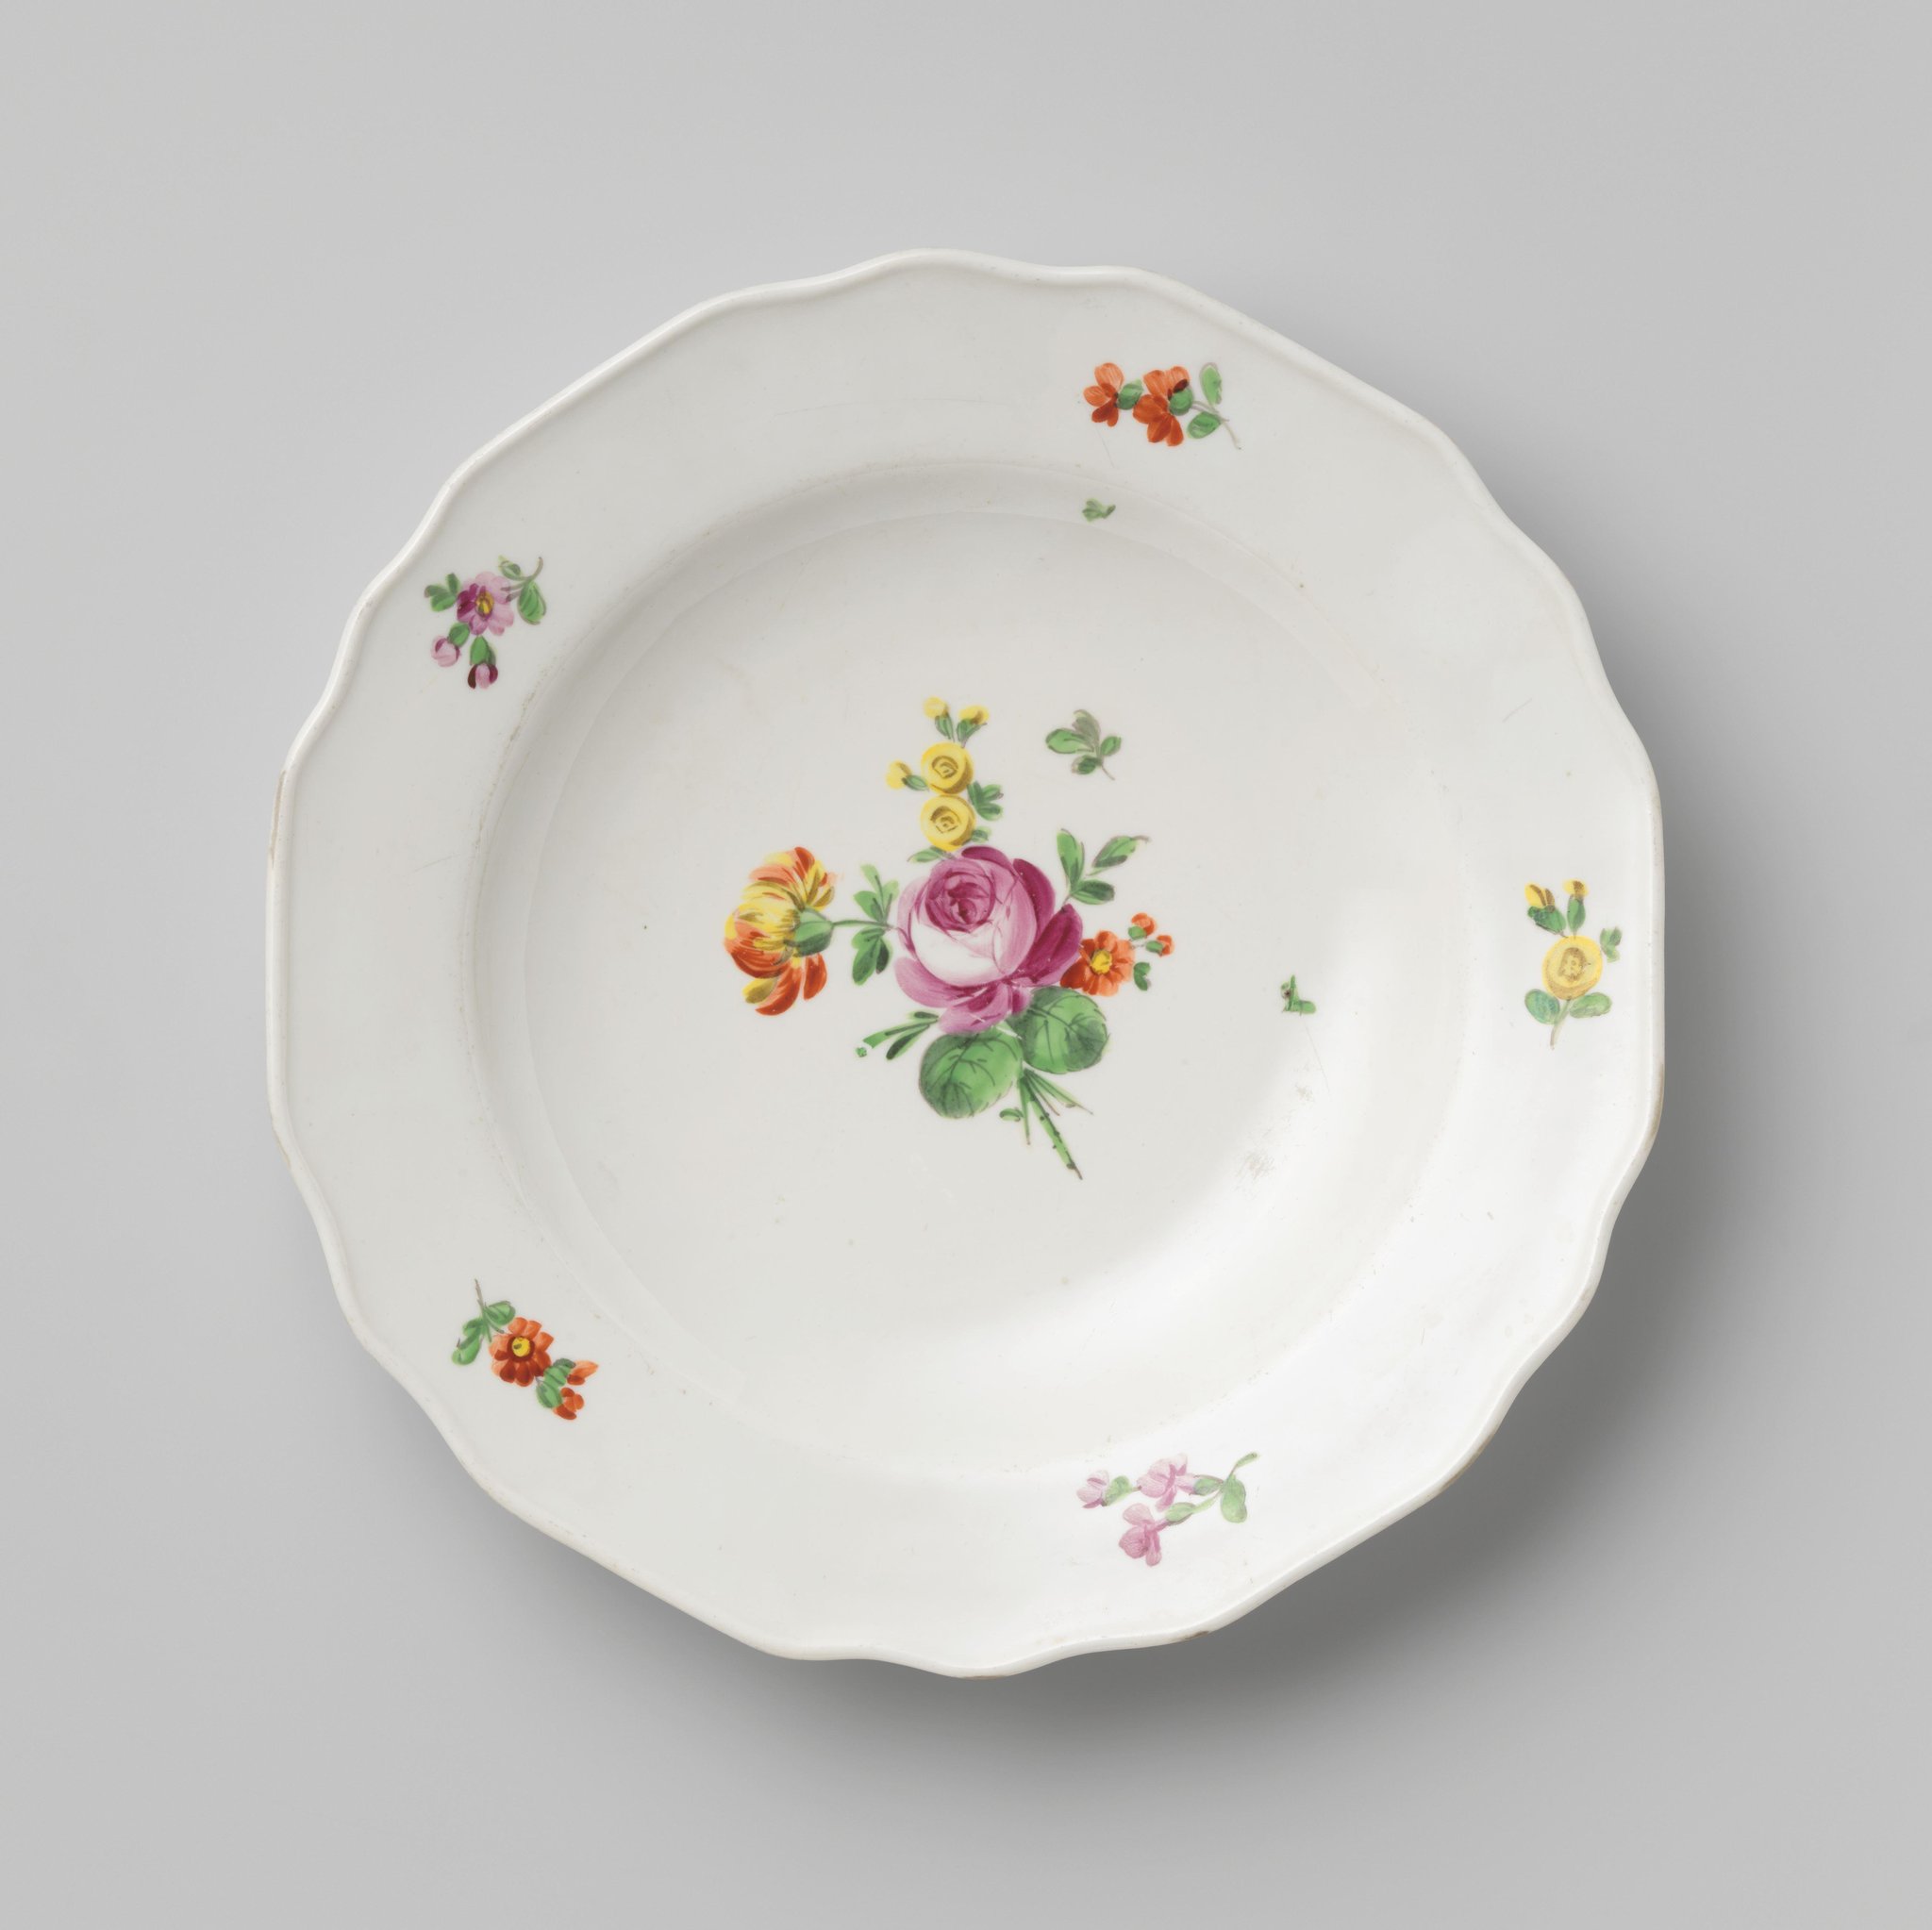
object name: service set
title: Plate with a bouquet and flower sprays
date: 1800-1849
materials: glaze, paint, porcelain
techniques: firing, forming, turning, vitrification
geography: vienna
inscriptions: mark: ‘schild/ P/ 30./ 23/ 35’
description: Bord van porselein met een gelobde rand, beschilderd op het glazuur in rood, roze, groen en geel. Op het plat een boeket van verschillende bloemen (o.a. pioenroos) omgeven door losse takjes en op de rand vijf bloemtakken. Gemerkt op de onderzijde met het schild, de letter P en de nummers 30., 23 en 35.